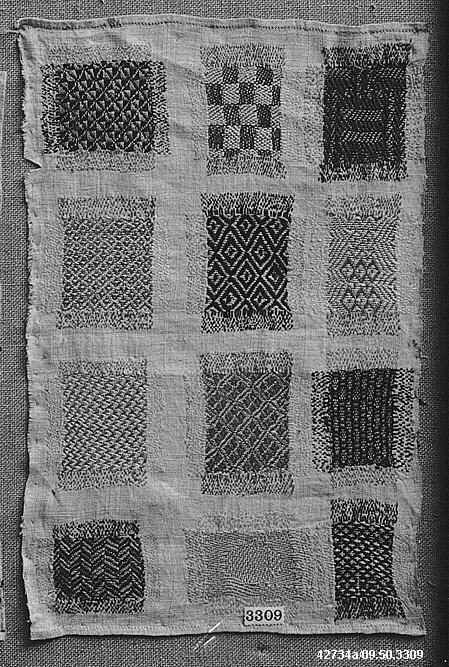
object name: sampler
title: Embroidered darning sampler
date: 1767-1800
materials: linen, silk